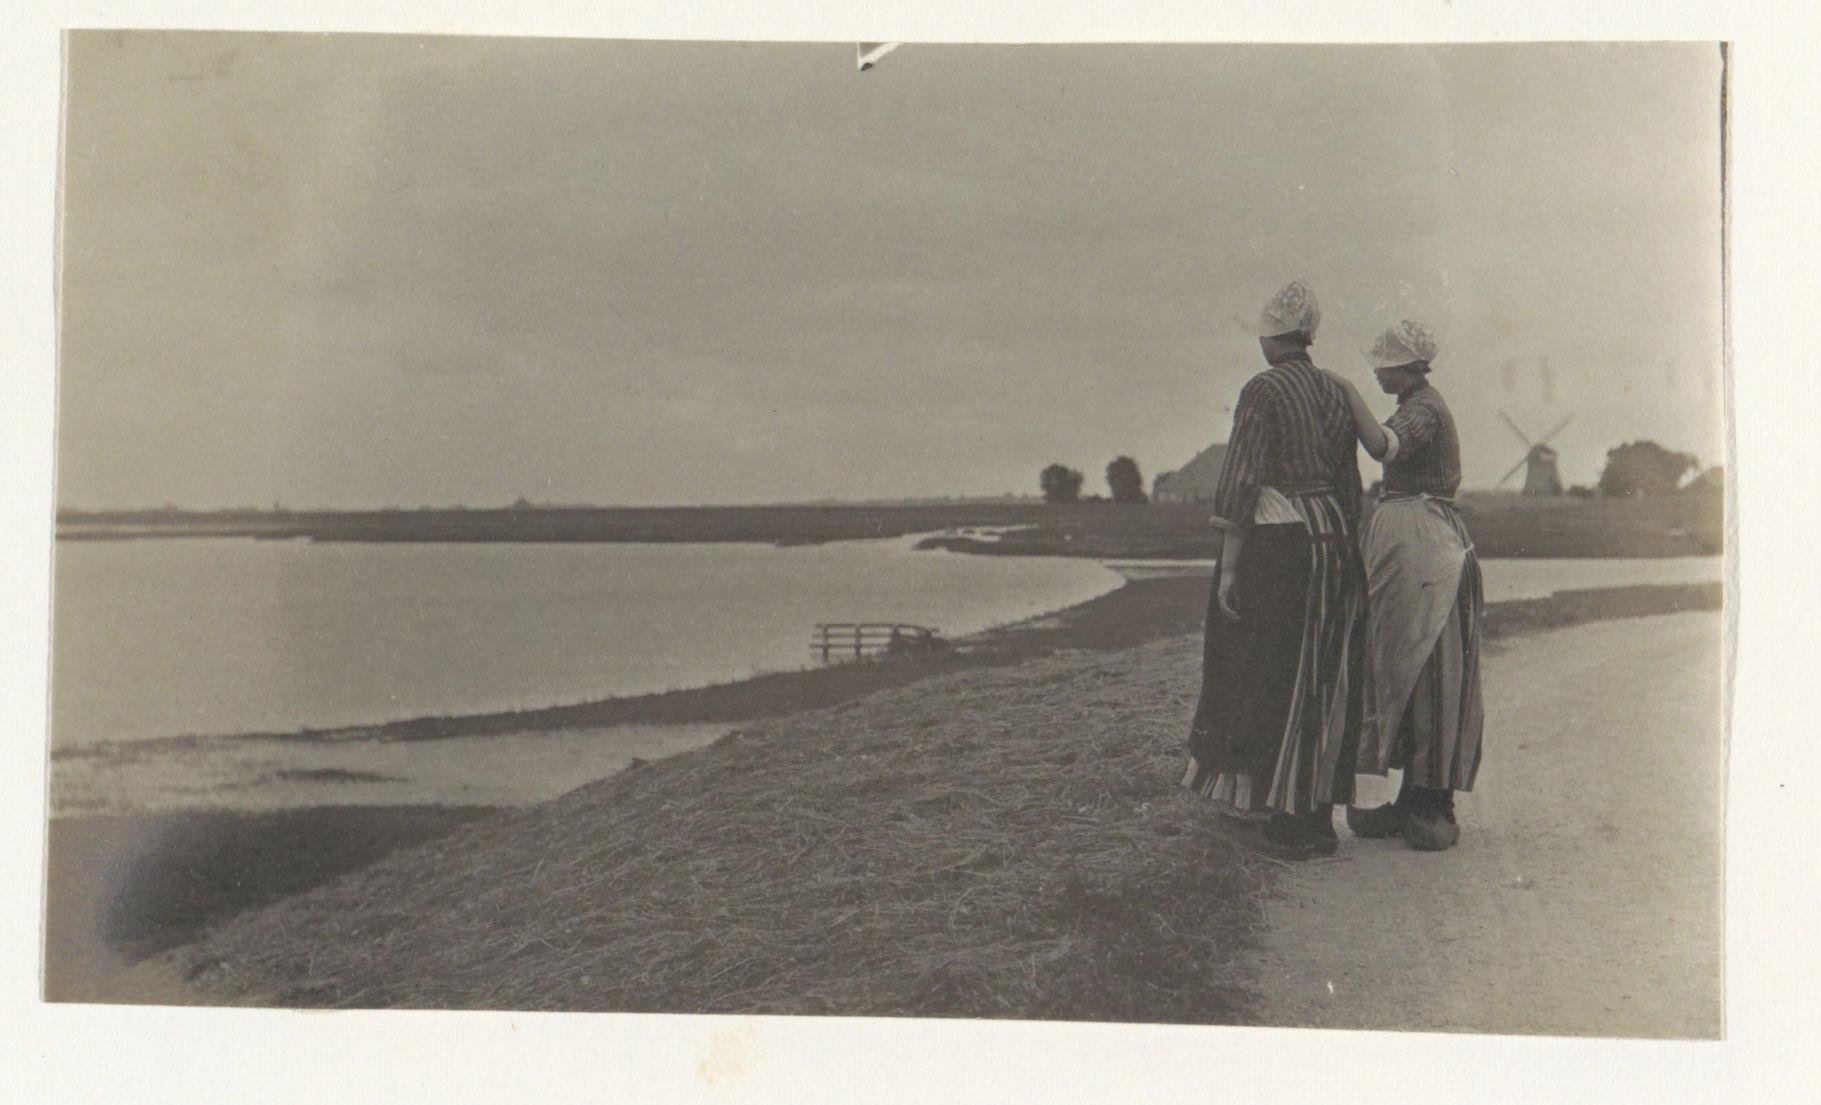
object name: photograph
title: Beladen zeilschip op een sloot, vermoedelijk in Noord-Holland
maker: george hidderley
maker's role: fotograaf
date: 1900-1910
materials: paper, photographic support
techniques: gelatin silver print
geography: north holland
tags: sailing-ship, sailing-boat, manoeuvering a ship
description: Onderdeel van fotoalbum met opnames van Volendam, Dordrecht, Gorinchem en Woudrichem.